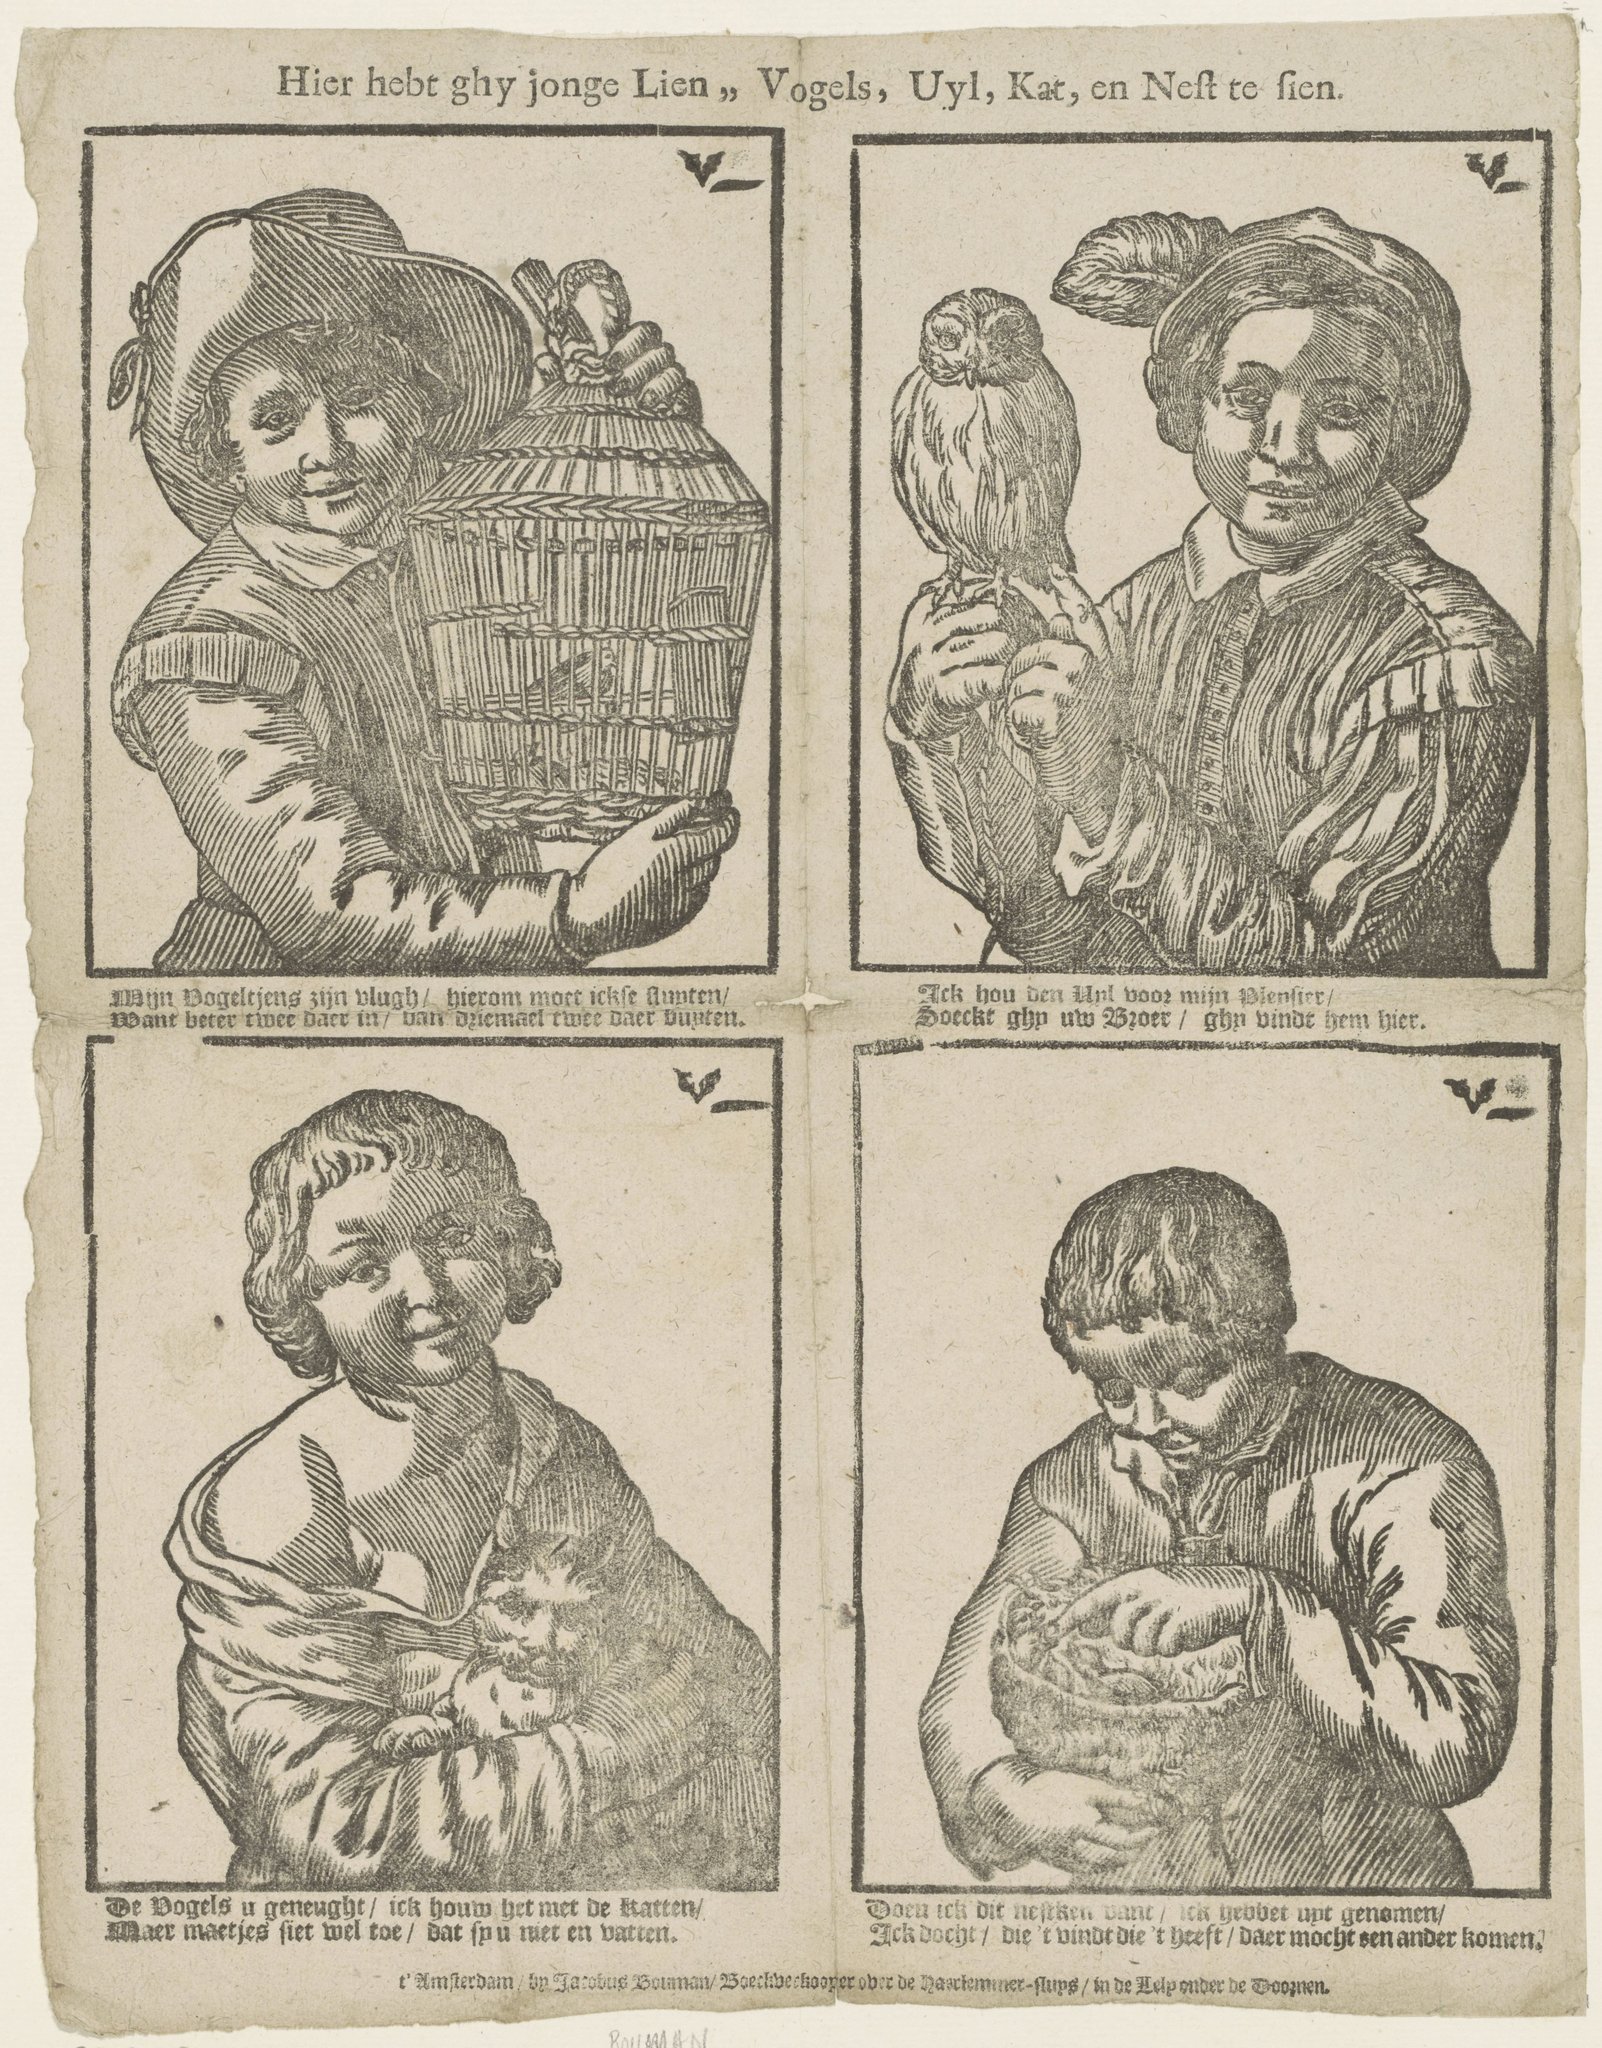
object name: popular print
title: Hier hebt ghy jonge lien, vogels, uyl, kat, en nest te sien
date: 1673-1704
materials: paper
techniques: letterpress printing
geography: amsterdam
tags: child playing with animals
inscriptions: collector's mark: Lugt 2760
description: Blad met vier voorstellingen van vier jongens met dieren: een jongen met een vogel in een kooi, een jongen met een uil, een jongen met een vogel in een nest en een jongen met een kat. Onder elke afbeelding een tweeregelig vers.